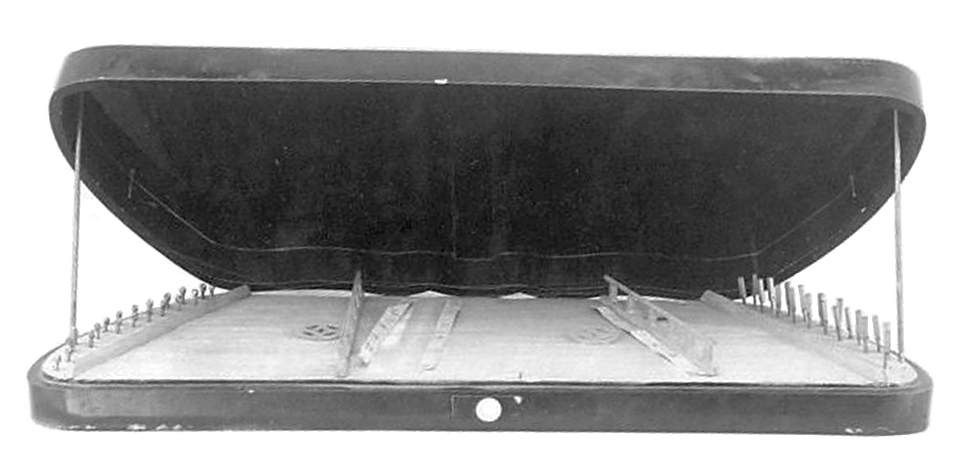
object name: yangqin 揚琴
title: Yangqin (揚琴)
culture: chinese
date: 1801-1900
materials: brass, wood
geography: china